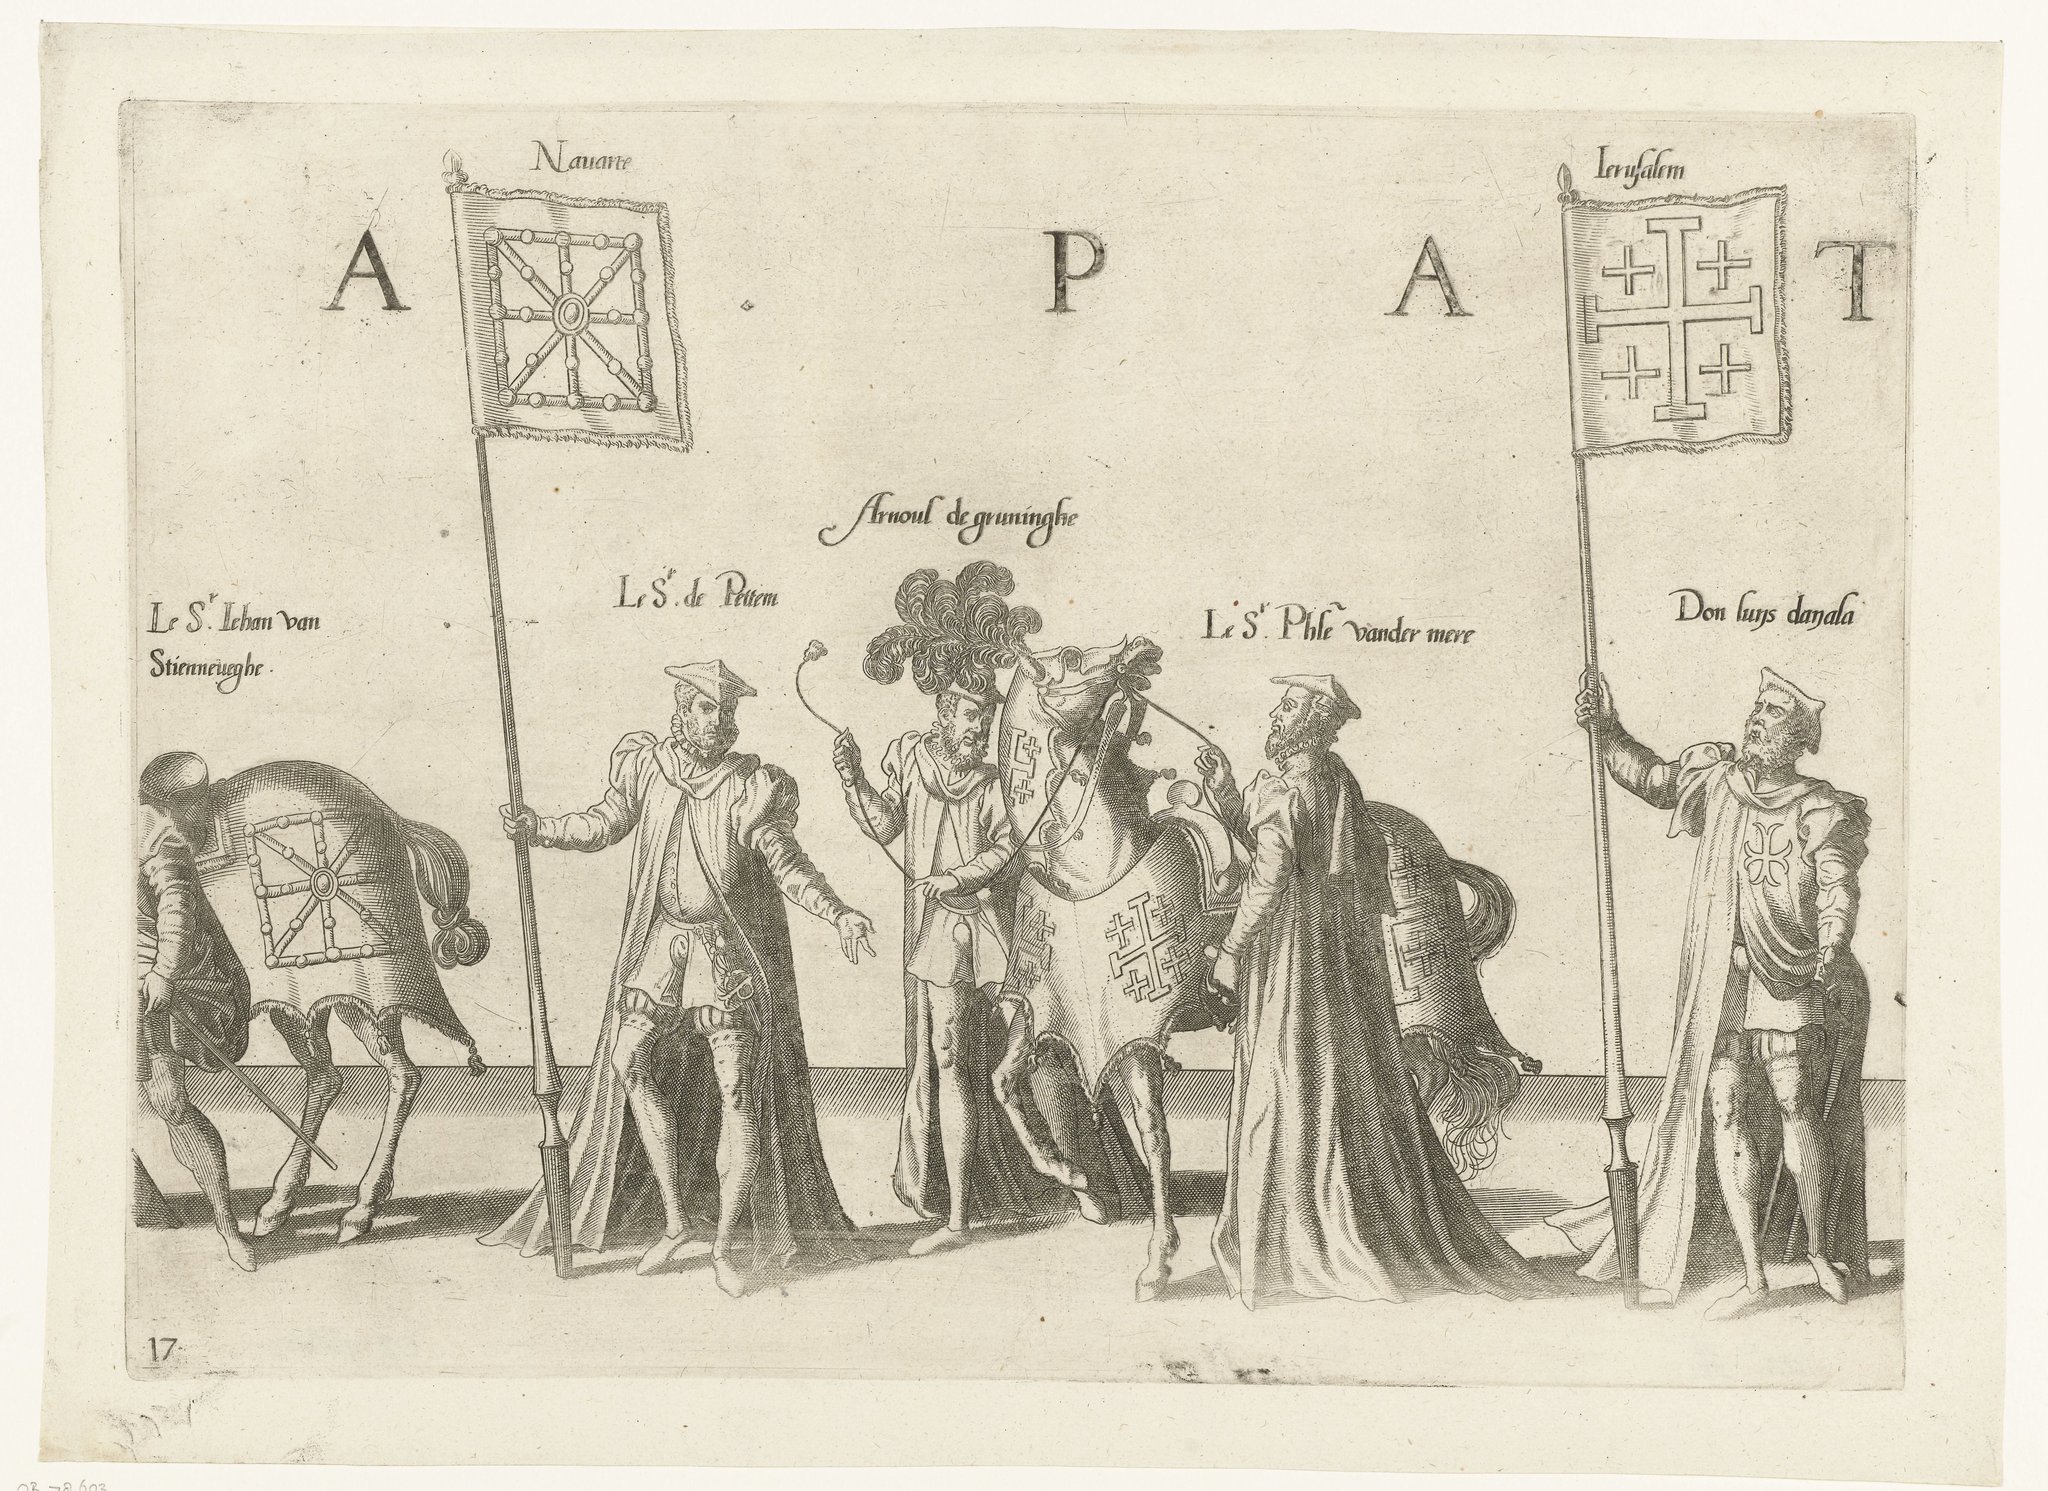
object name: print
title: Begrafenisoptocht van keizer Karel V, 1558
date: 1559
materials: paper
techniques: engraving, etching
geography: southern netherlands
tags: ghent, charles v (holy roman emperor and king of spain), cortege, funeral procession, brussels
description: Vier deelnemers aan de optocht, paarden en de vaandels met de wapens van Navarra en Jeruzalem. Onderdeel van de prentreeks van de Begrafenisoptocht van keizer Karel V op 29 december 1558 te Brussel.